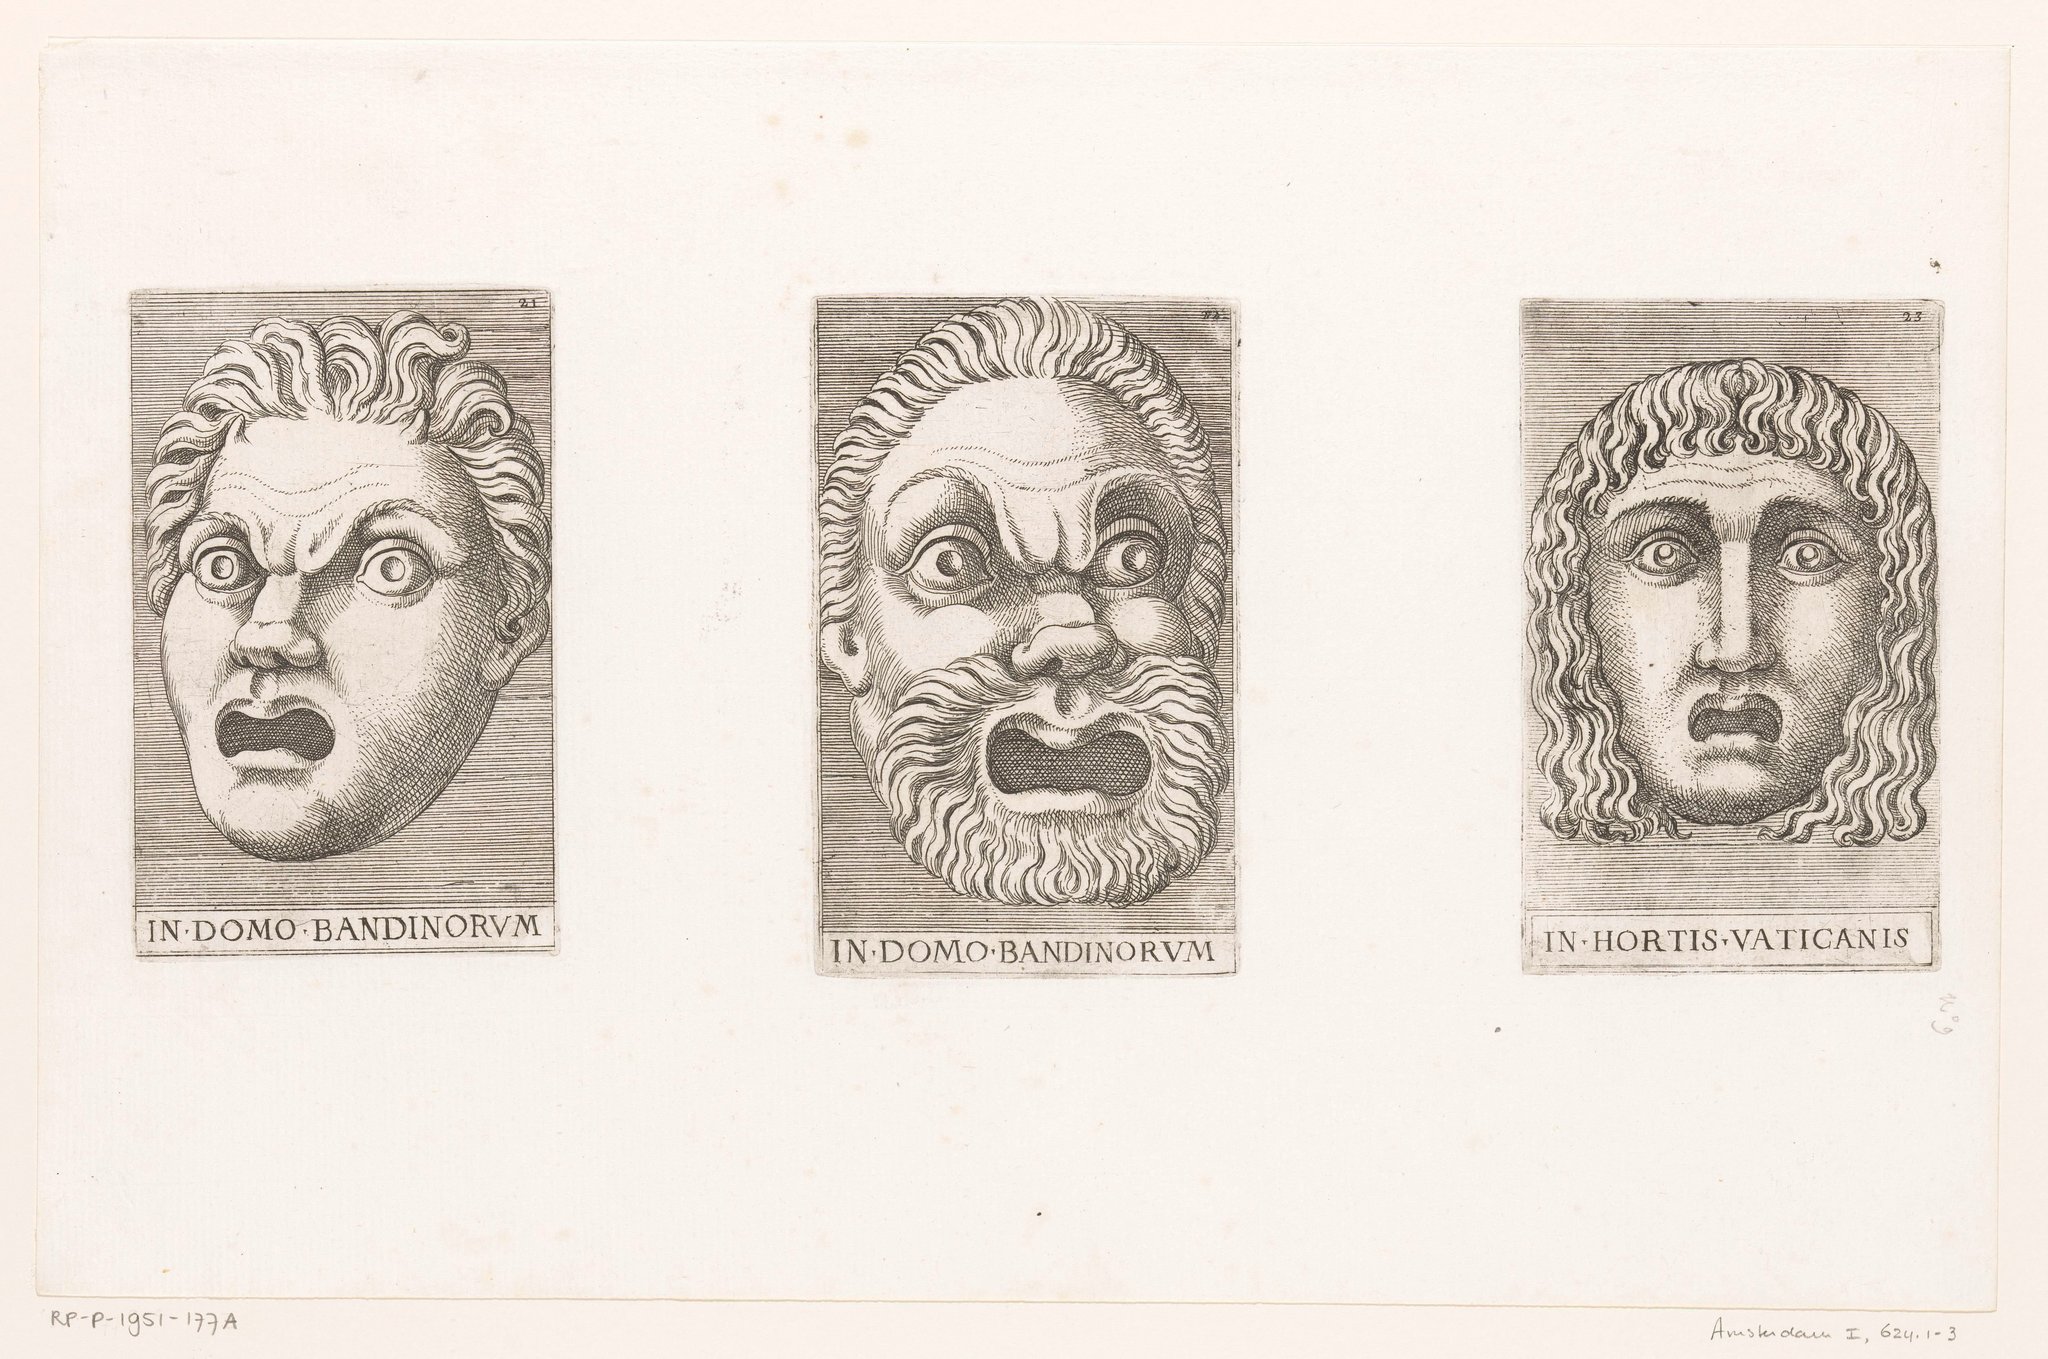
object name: print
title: Drie antieke maskers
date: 1540-1585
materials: paper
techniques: etching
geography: italy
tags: mask, mask, mascaron ~ ornament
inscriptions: collector's mark: Lugt 2228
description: Deze prenten maken deel uit van een reeks van 38 genummerde prenten van maskers. Het begint met twintig voorstellingen van groteske maskers en één ongenummerde ronde prent met het hoofd van Silenus. Daar op volgen 18 voorstellingen van antieke maskers. Op basis van de doornummering kunnen ook de laatste 18 prenten worden toegeschreven aan Adamo Scultori. Telkens zijn er drie platen op één blad bij elkaar gedrukt.